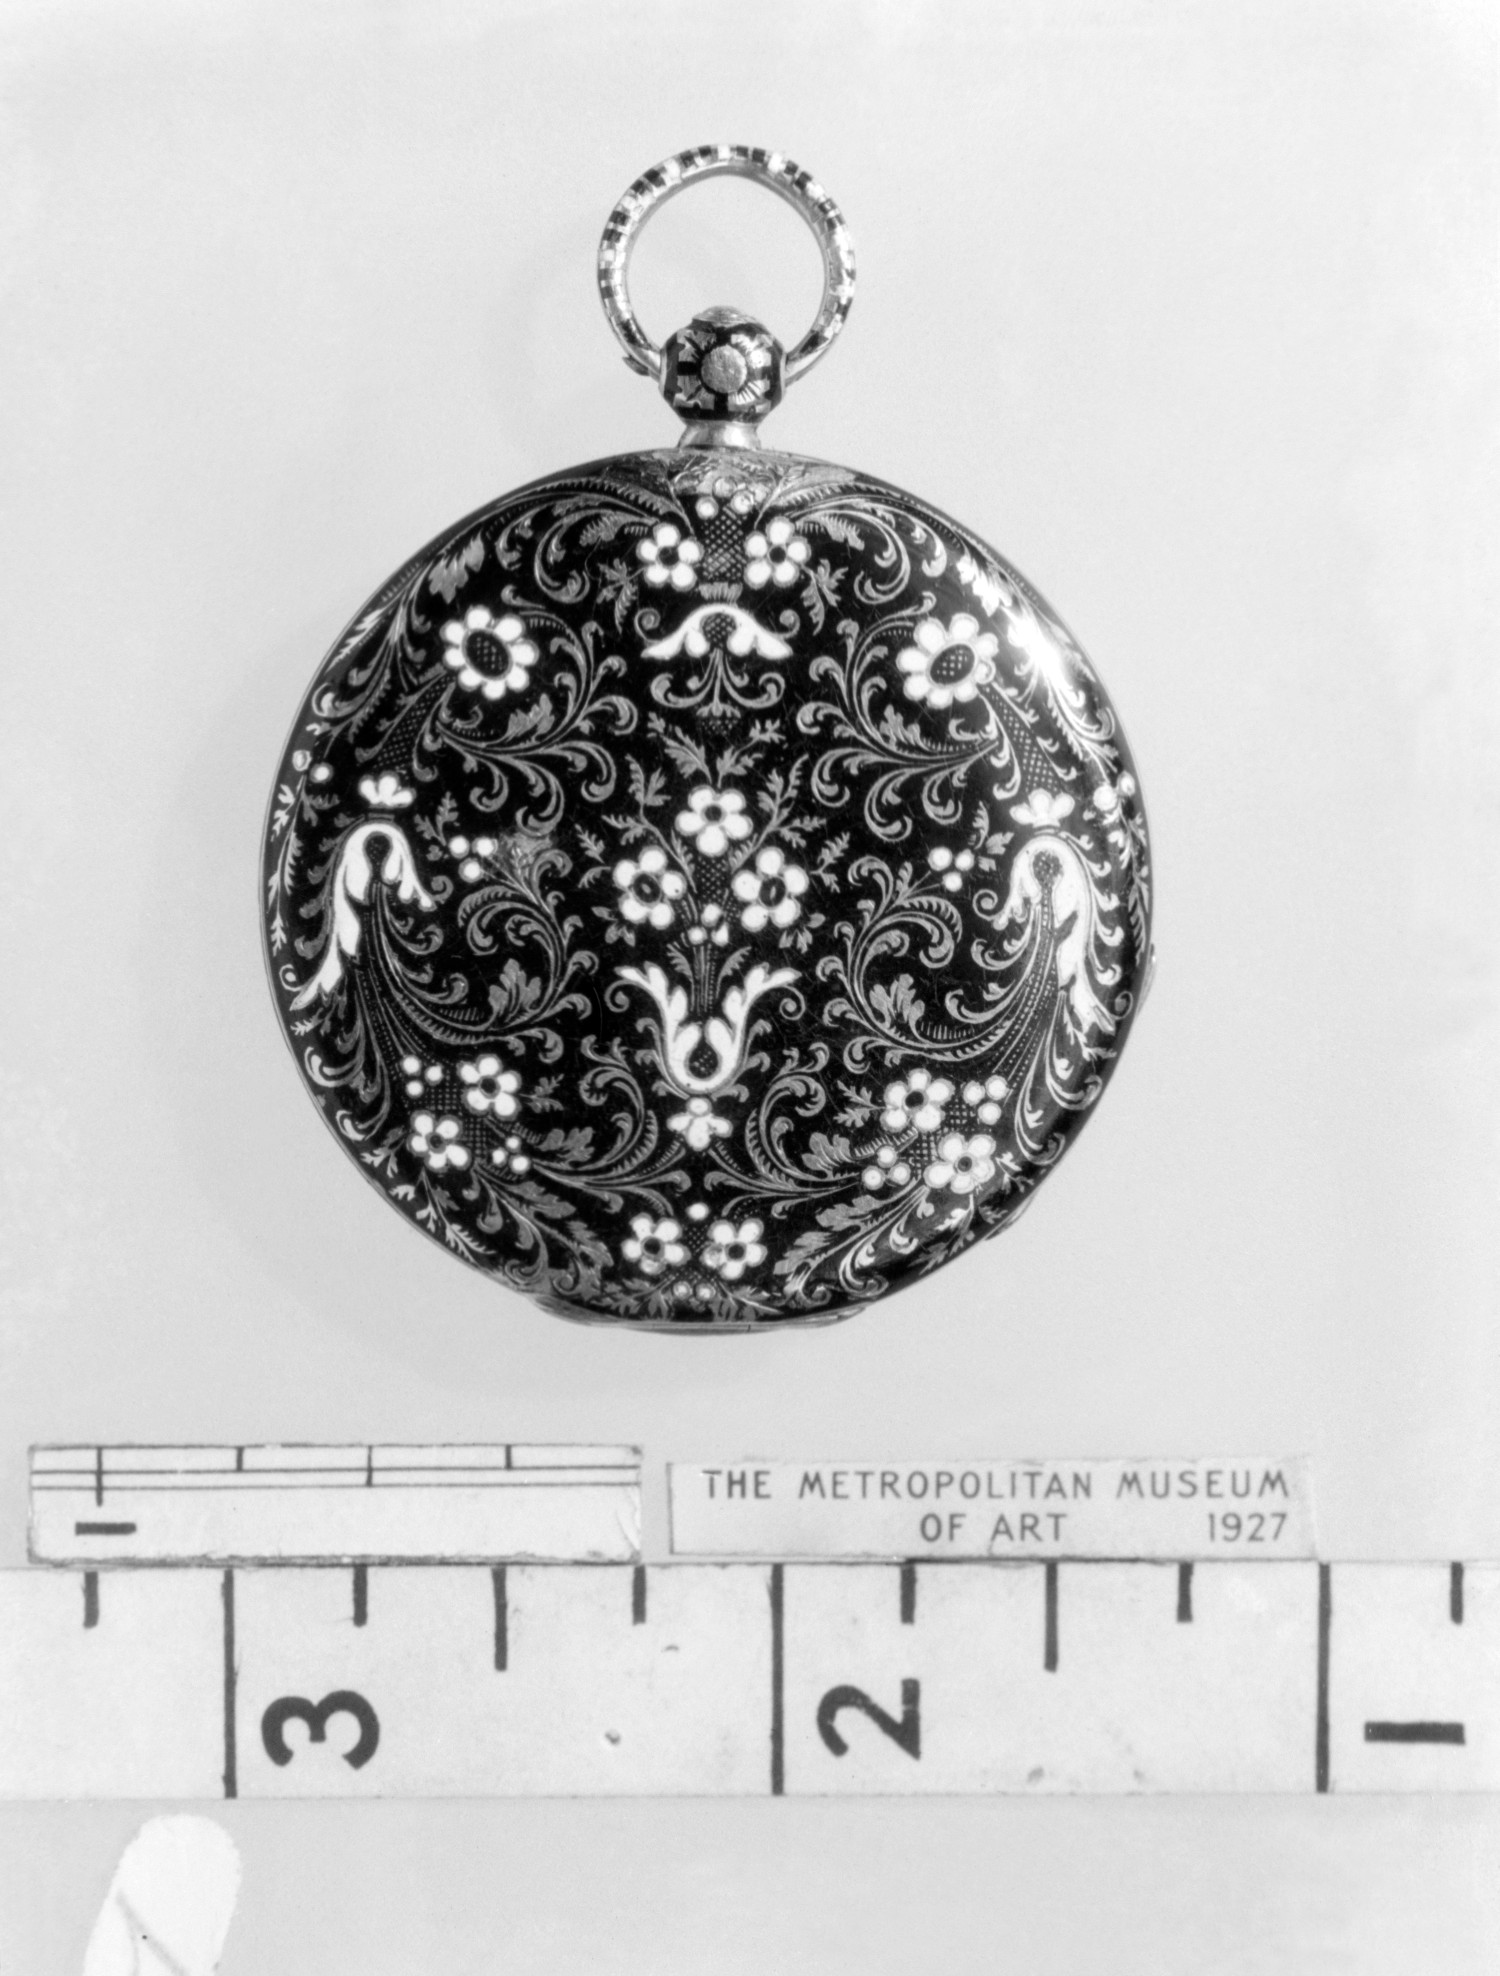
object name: watch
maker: charles oudin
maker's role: maker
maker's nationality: french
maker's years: 1768-1840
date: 1822-1838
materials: enamel, gold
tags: flowers,leaves